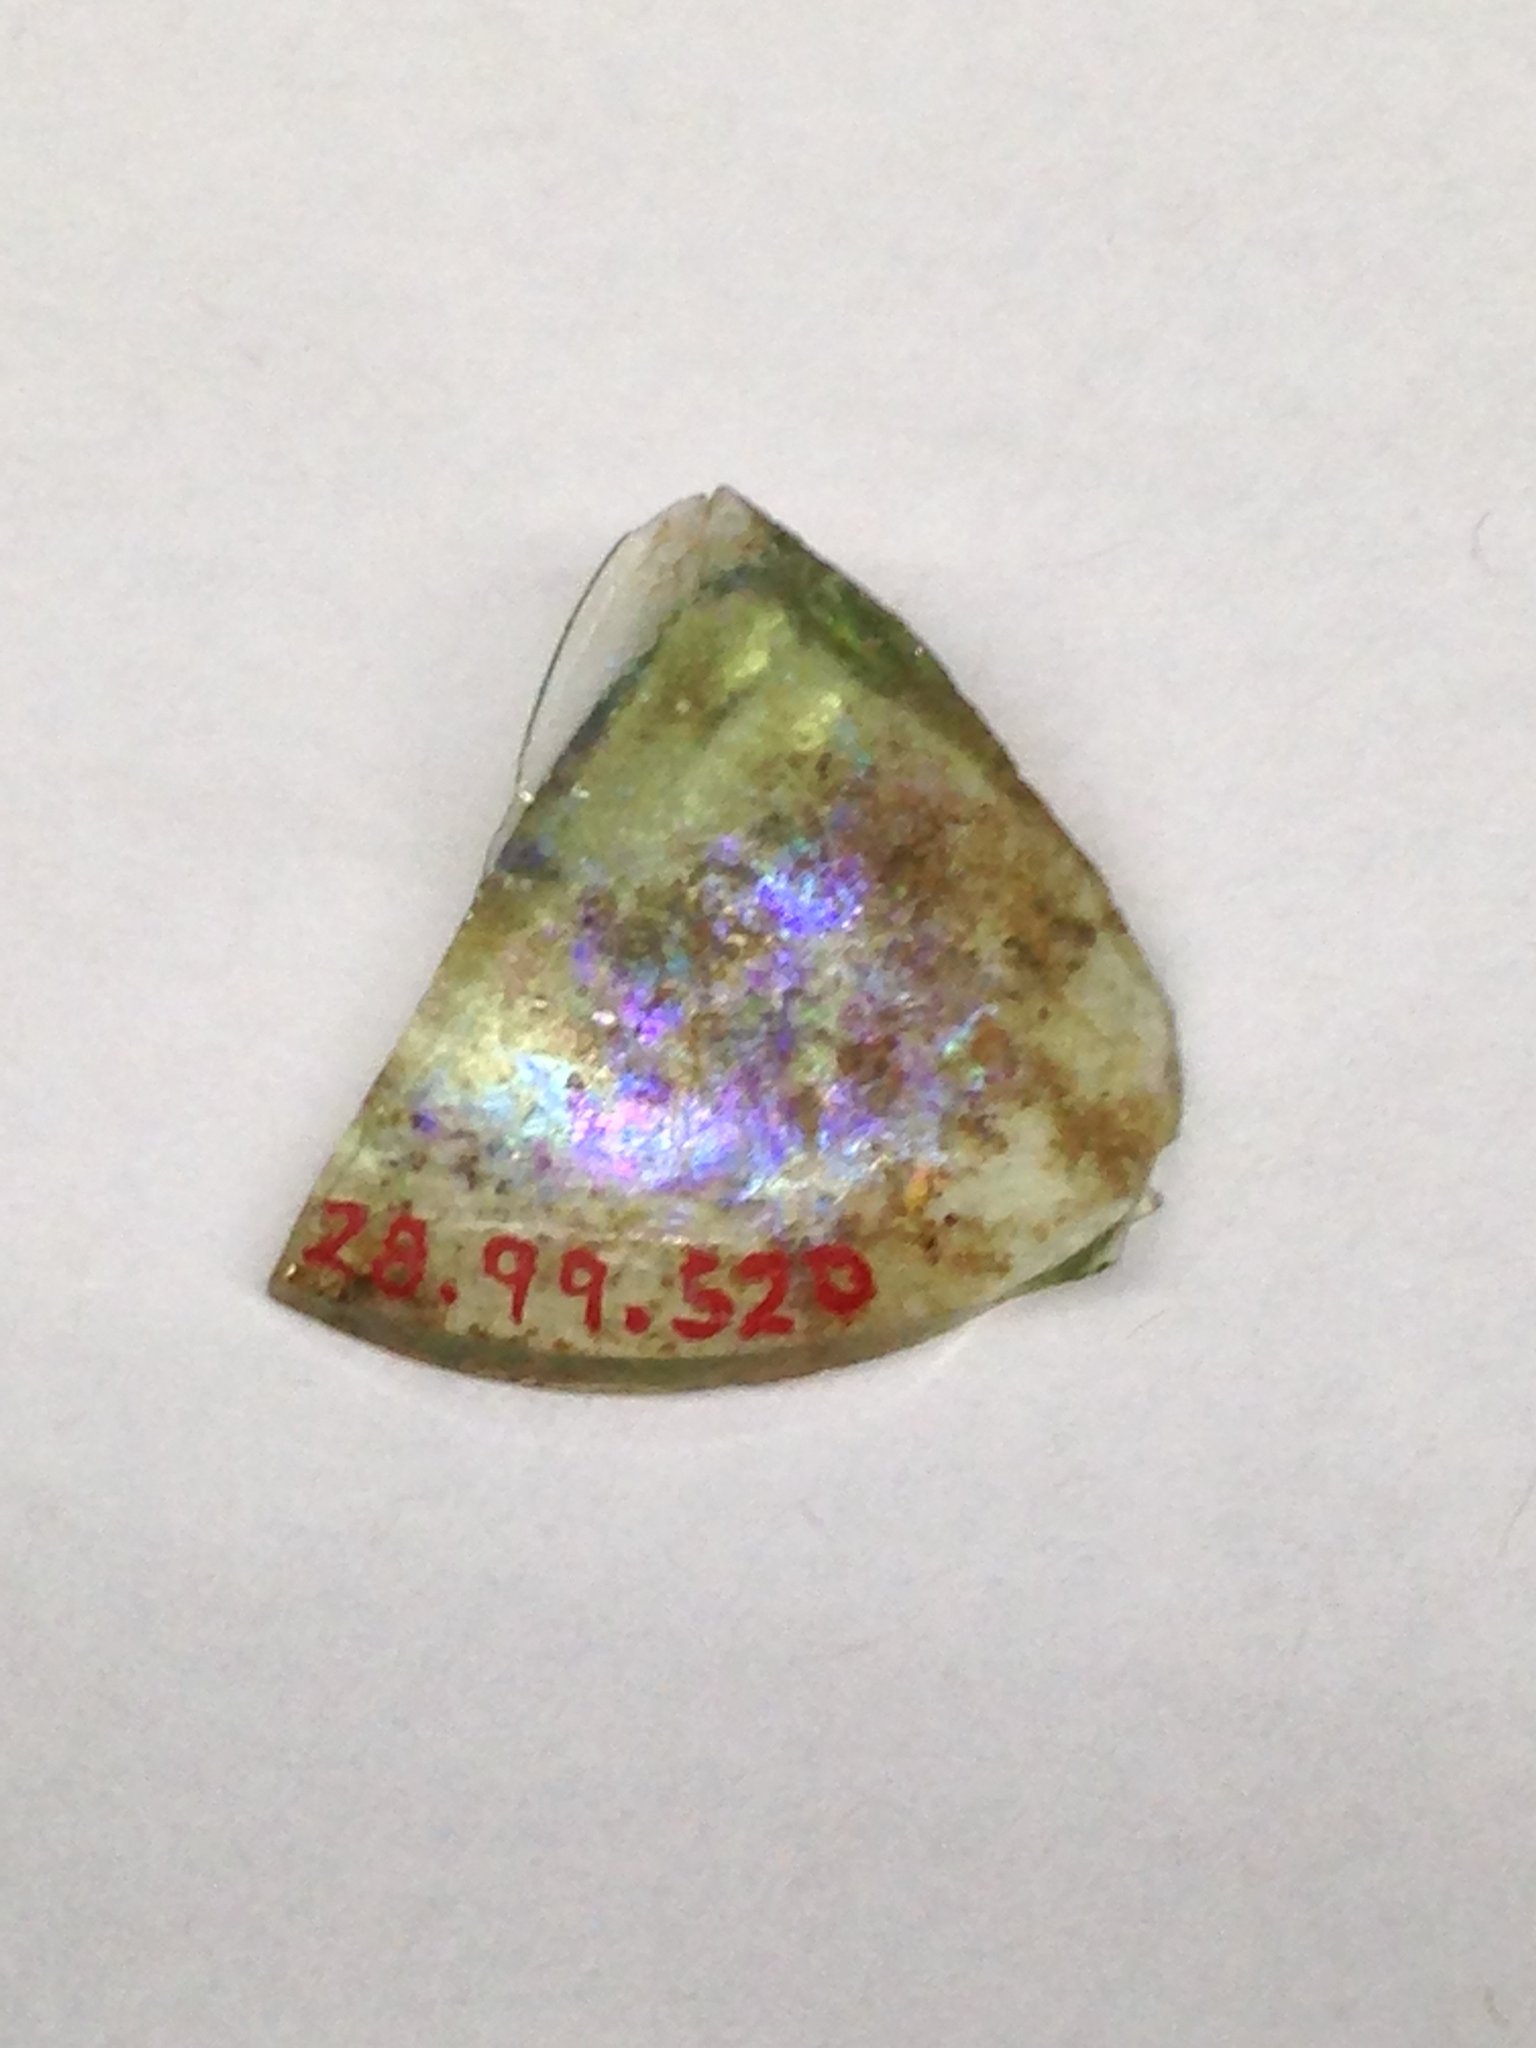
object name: fragment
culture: european or middle eastern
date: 1150-1250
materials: ceramic, glass